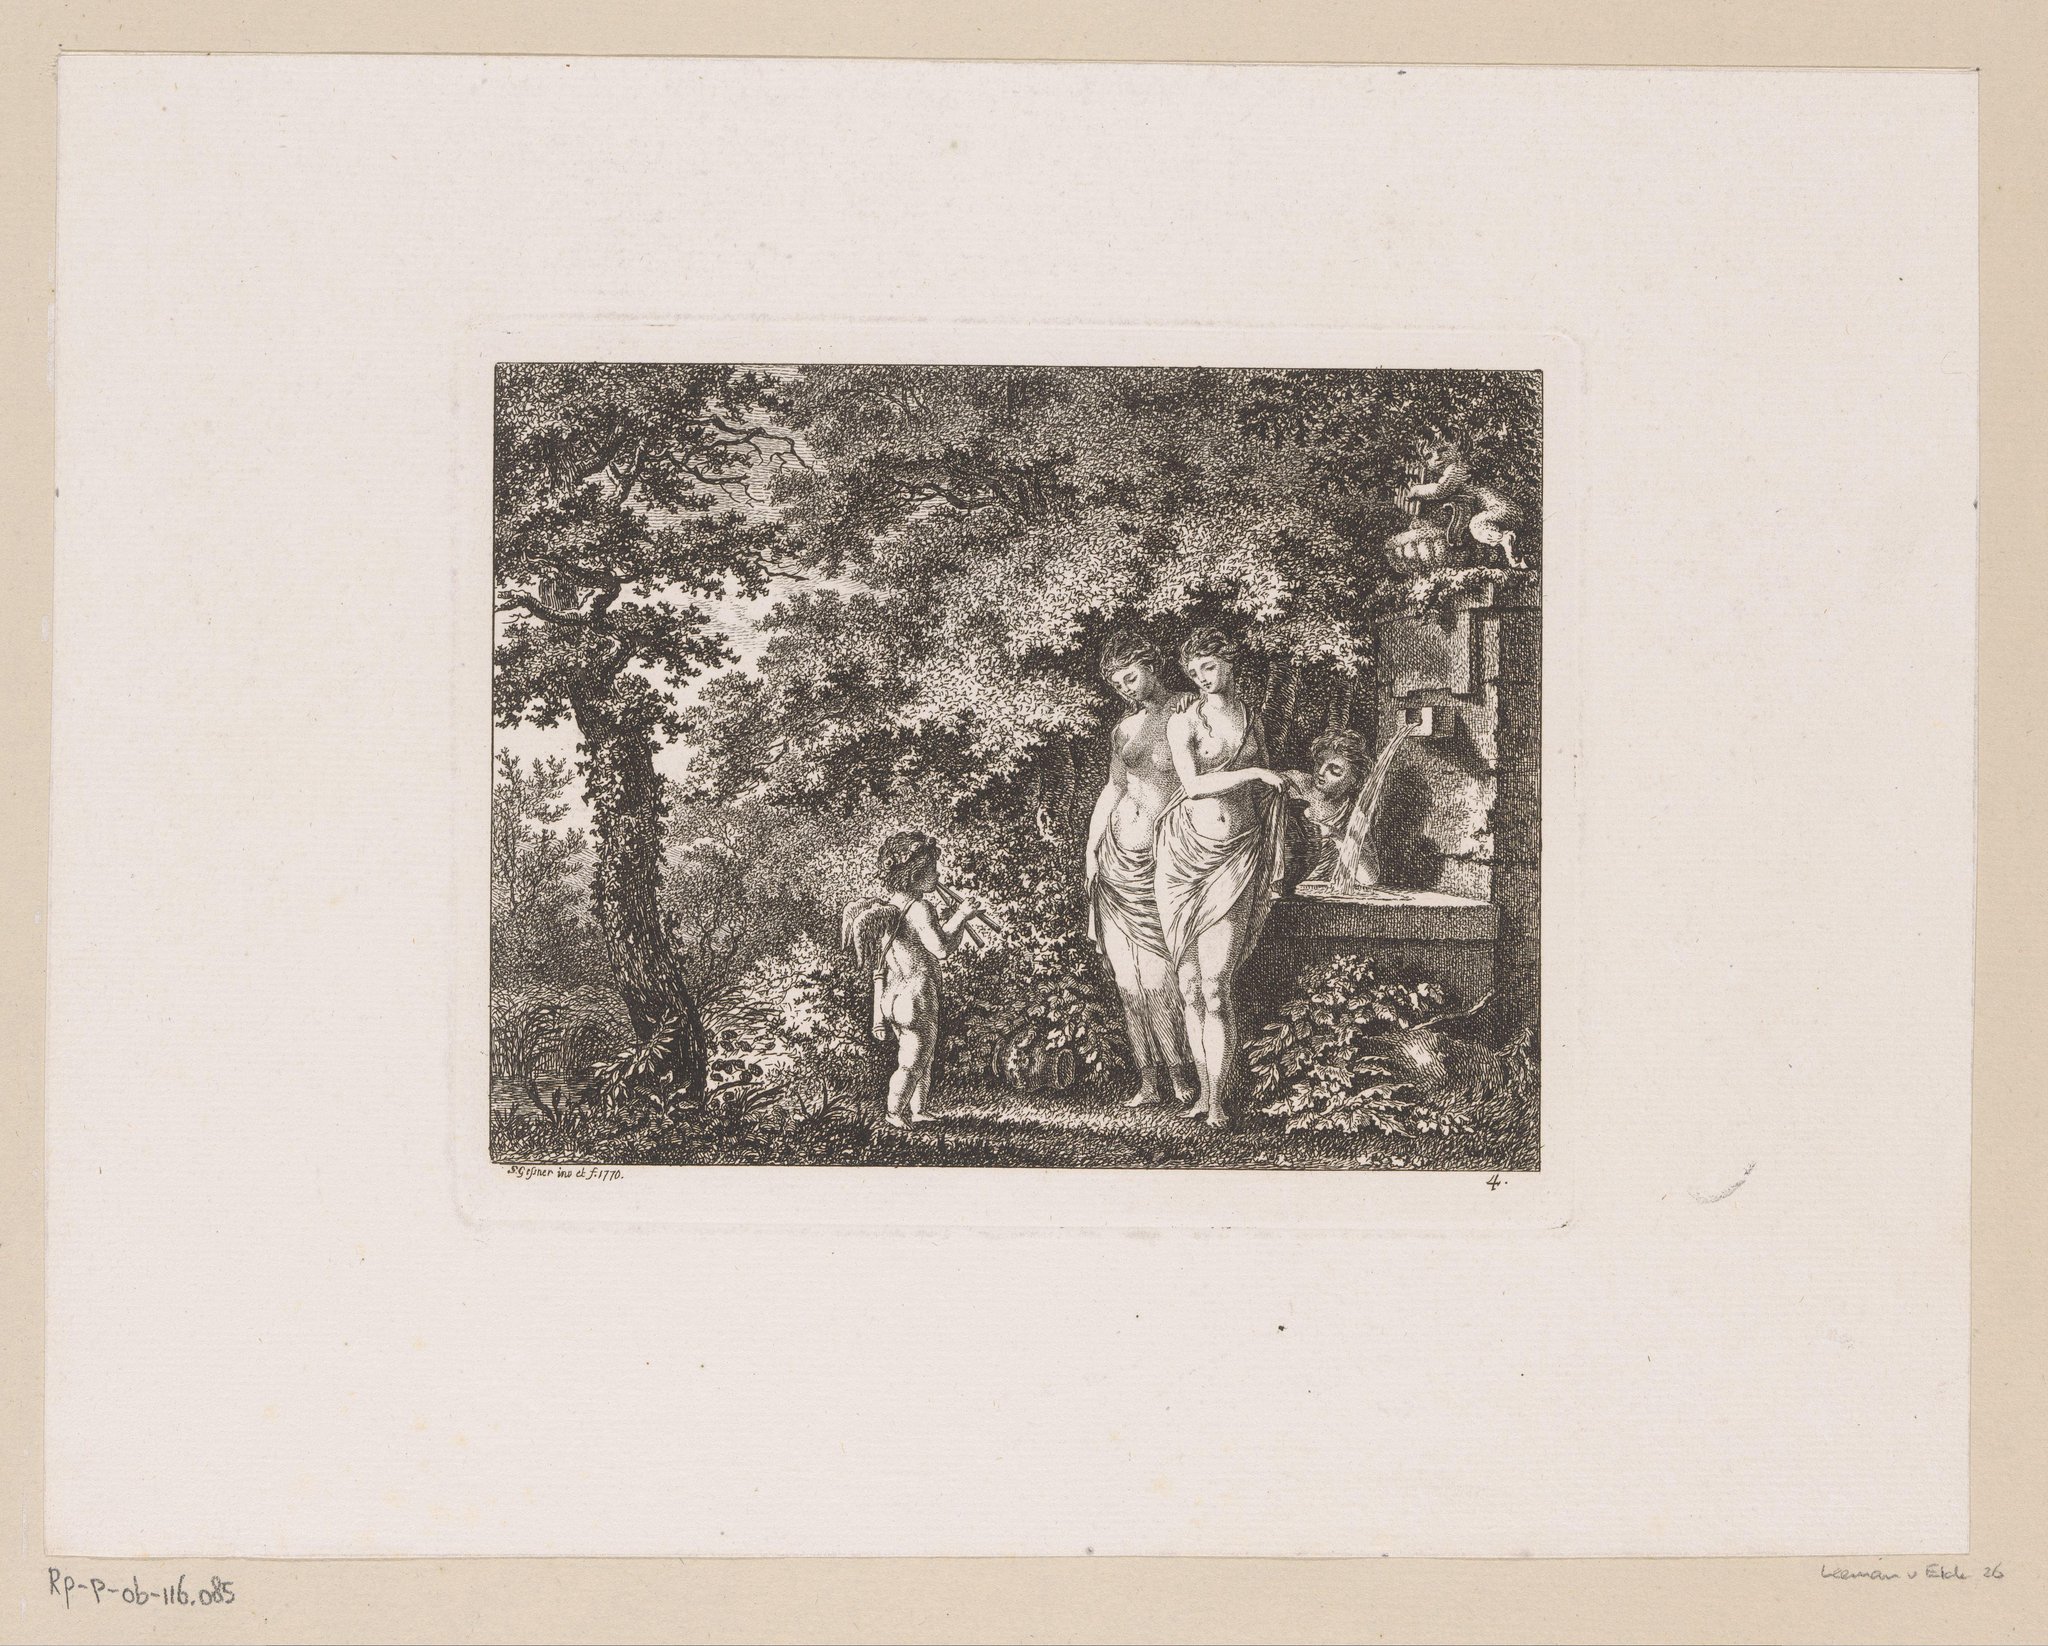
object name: print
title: Landschappen met mythologische figuren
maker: salomon gessner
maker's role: painter, print maker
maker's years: 1730-1788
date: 1770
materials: paper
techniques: etching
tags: nymphs (in general); 'ninfe in commune' (ripa), spring (fluids extracted from the earth), cupids: 'amores', 'amoretti', 'putti', flute, aulos, tibia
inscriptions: collector's mark: Lugt 240